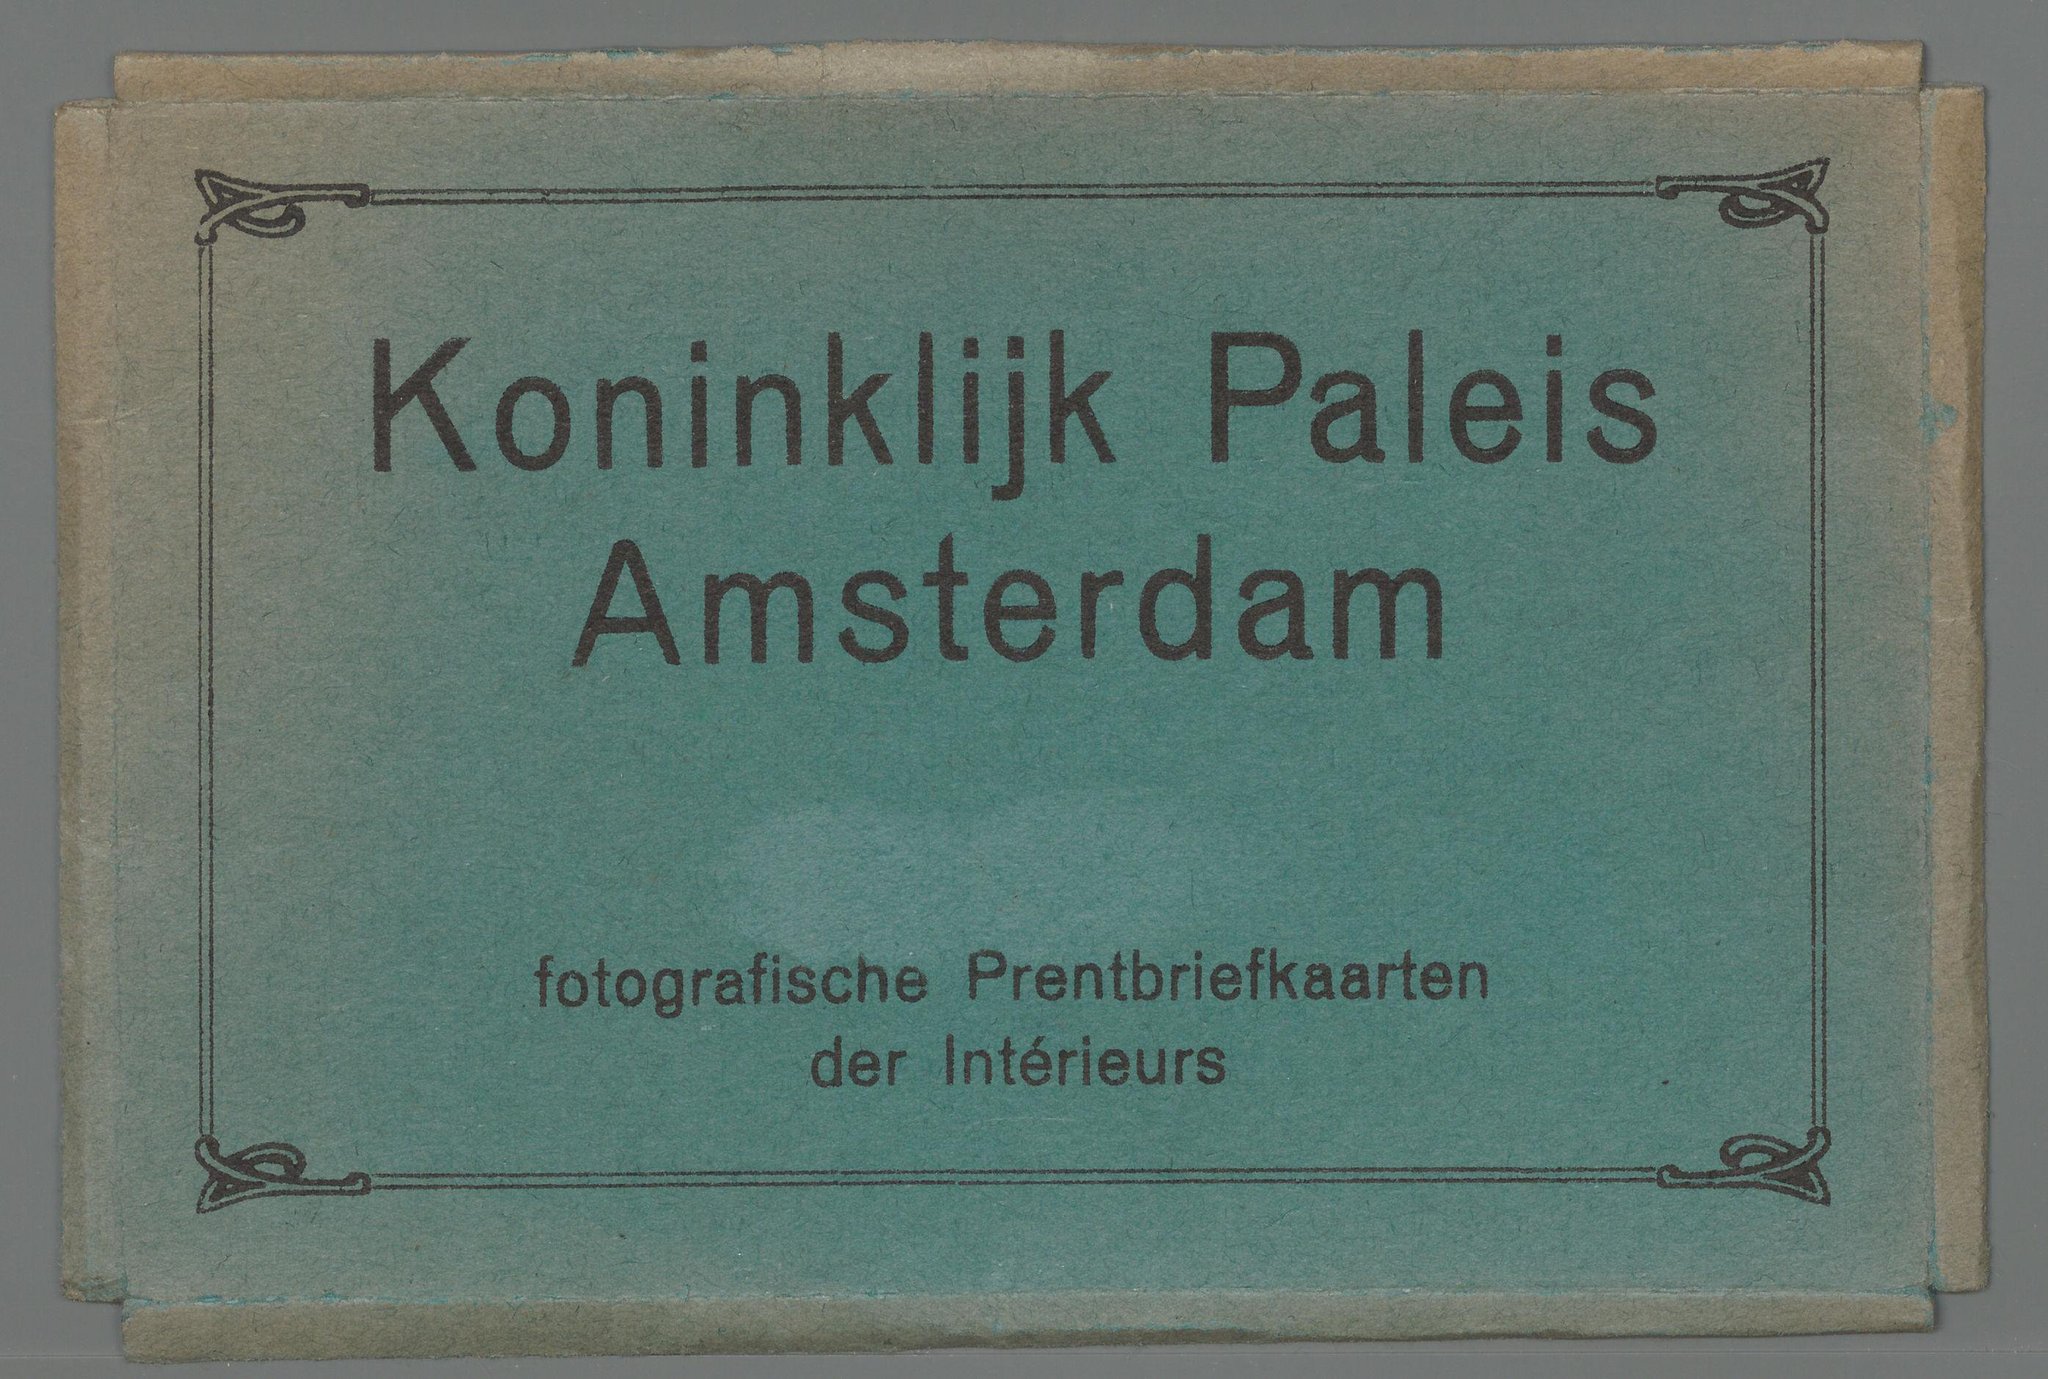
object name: wrapper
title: Koninklijk Paleis Amsterdam. Fotografische Prentbriefkaarten der Intérieurs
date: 1932-1947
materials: cardboard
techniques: letterpress printing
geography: the hague